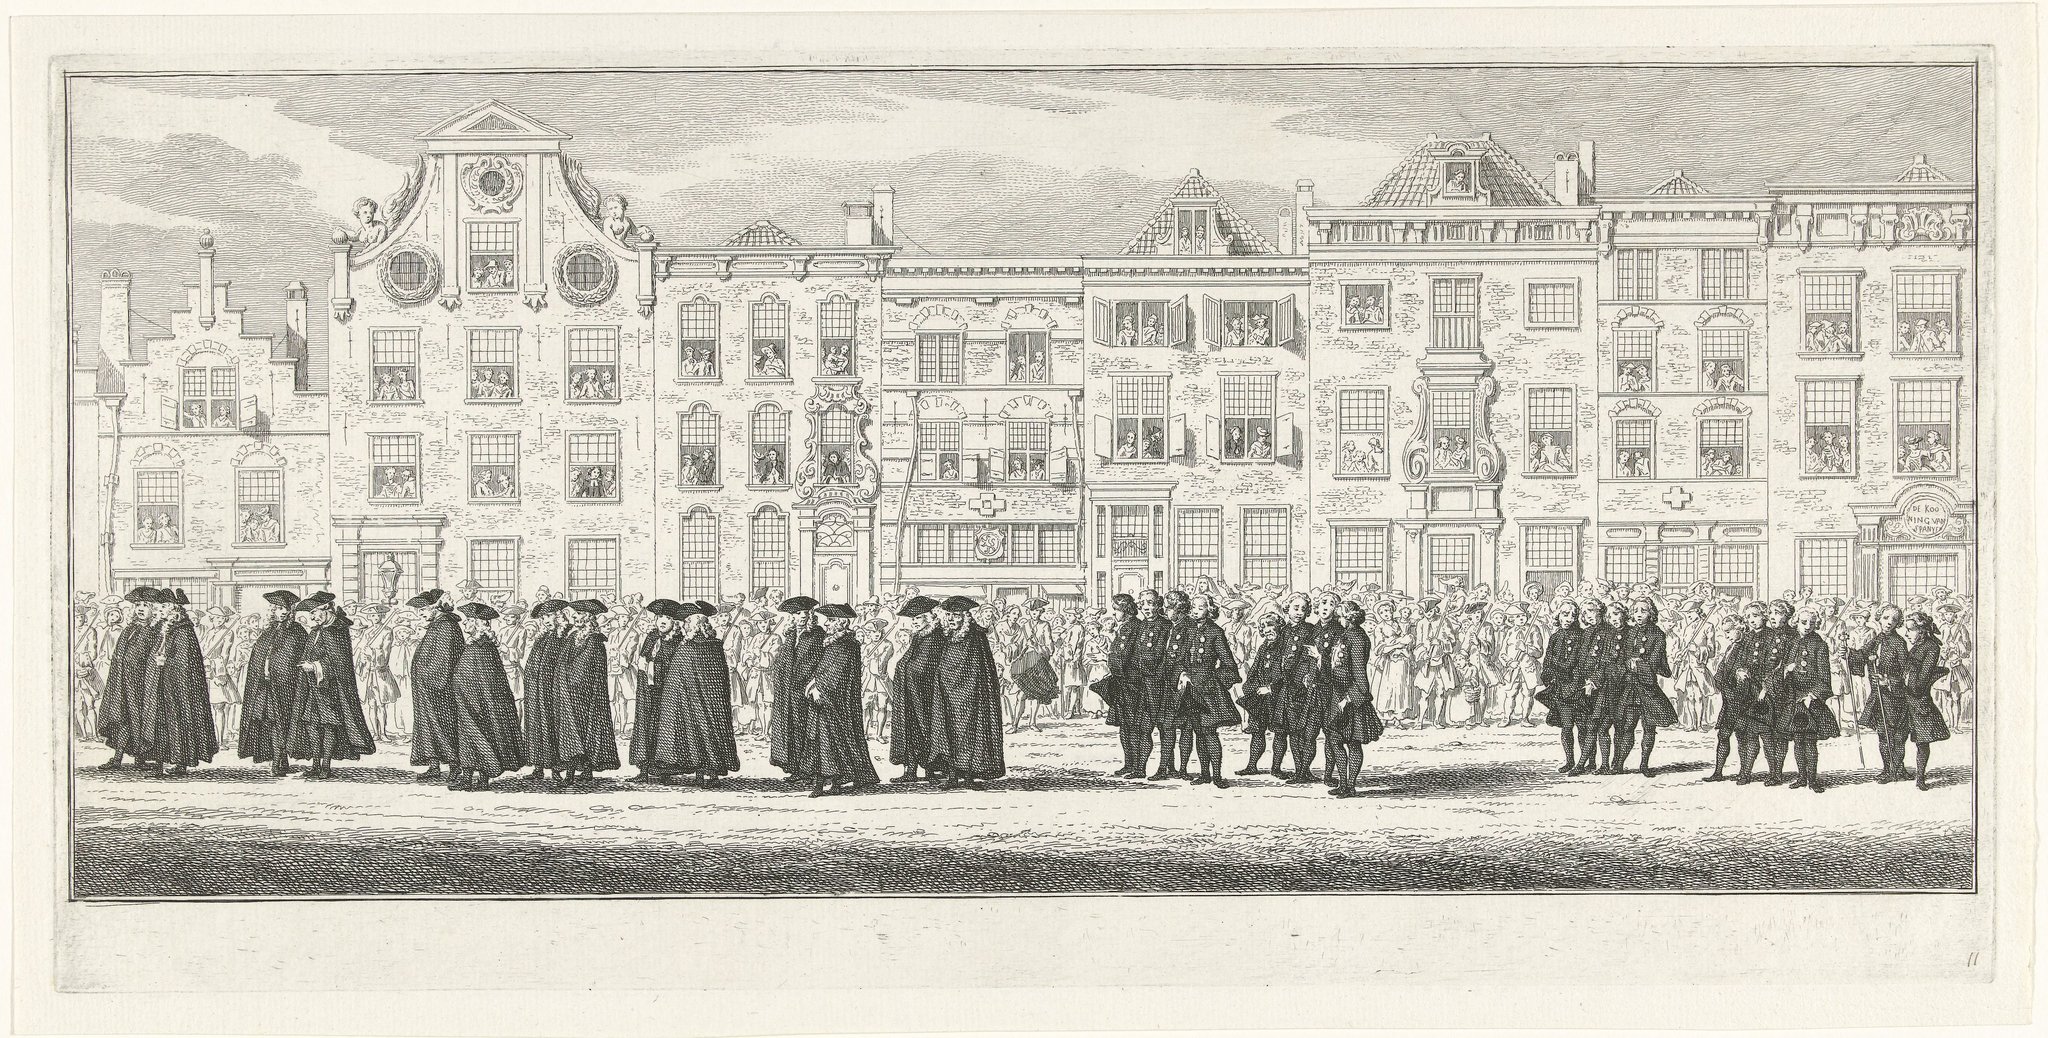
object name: print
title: Lijkstoet van prinses Anna van Hannover te Delft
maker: simon fokke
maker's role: draughtsman, print maker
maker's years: 1712-1784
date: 1759-1761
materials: paper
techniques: etching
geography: amsterdam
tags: the hague, anna van hannover, cortege, funeral procession, delft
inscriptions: collector's mark: Lugt 2228, serial number: ‘11’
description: Leden en personeel van de Staten van Holland en West-Friesland. Onderdeel van een serie van 16 platen in etsdruk van de lijkstatie van de op 23 februari 1759 te Delft begraven prinses Anna van Hannover.